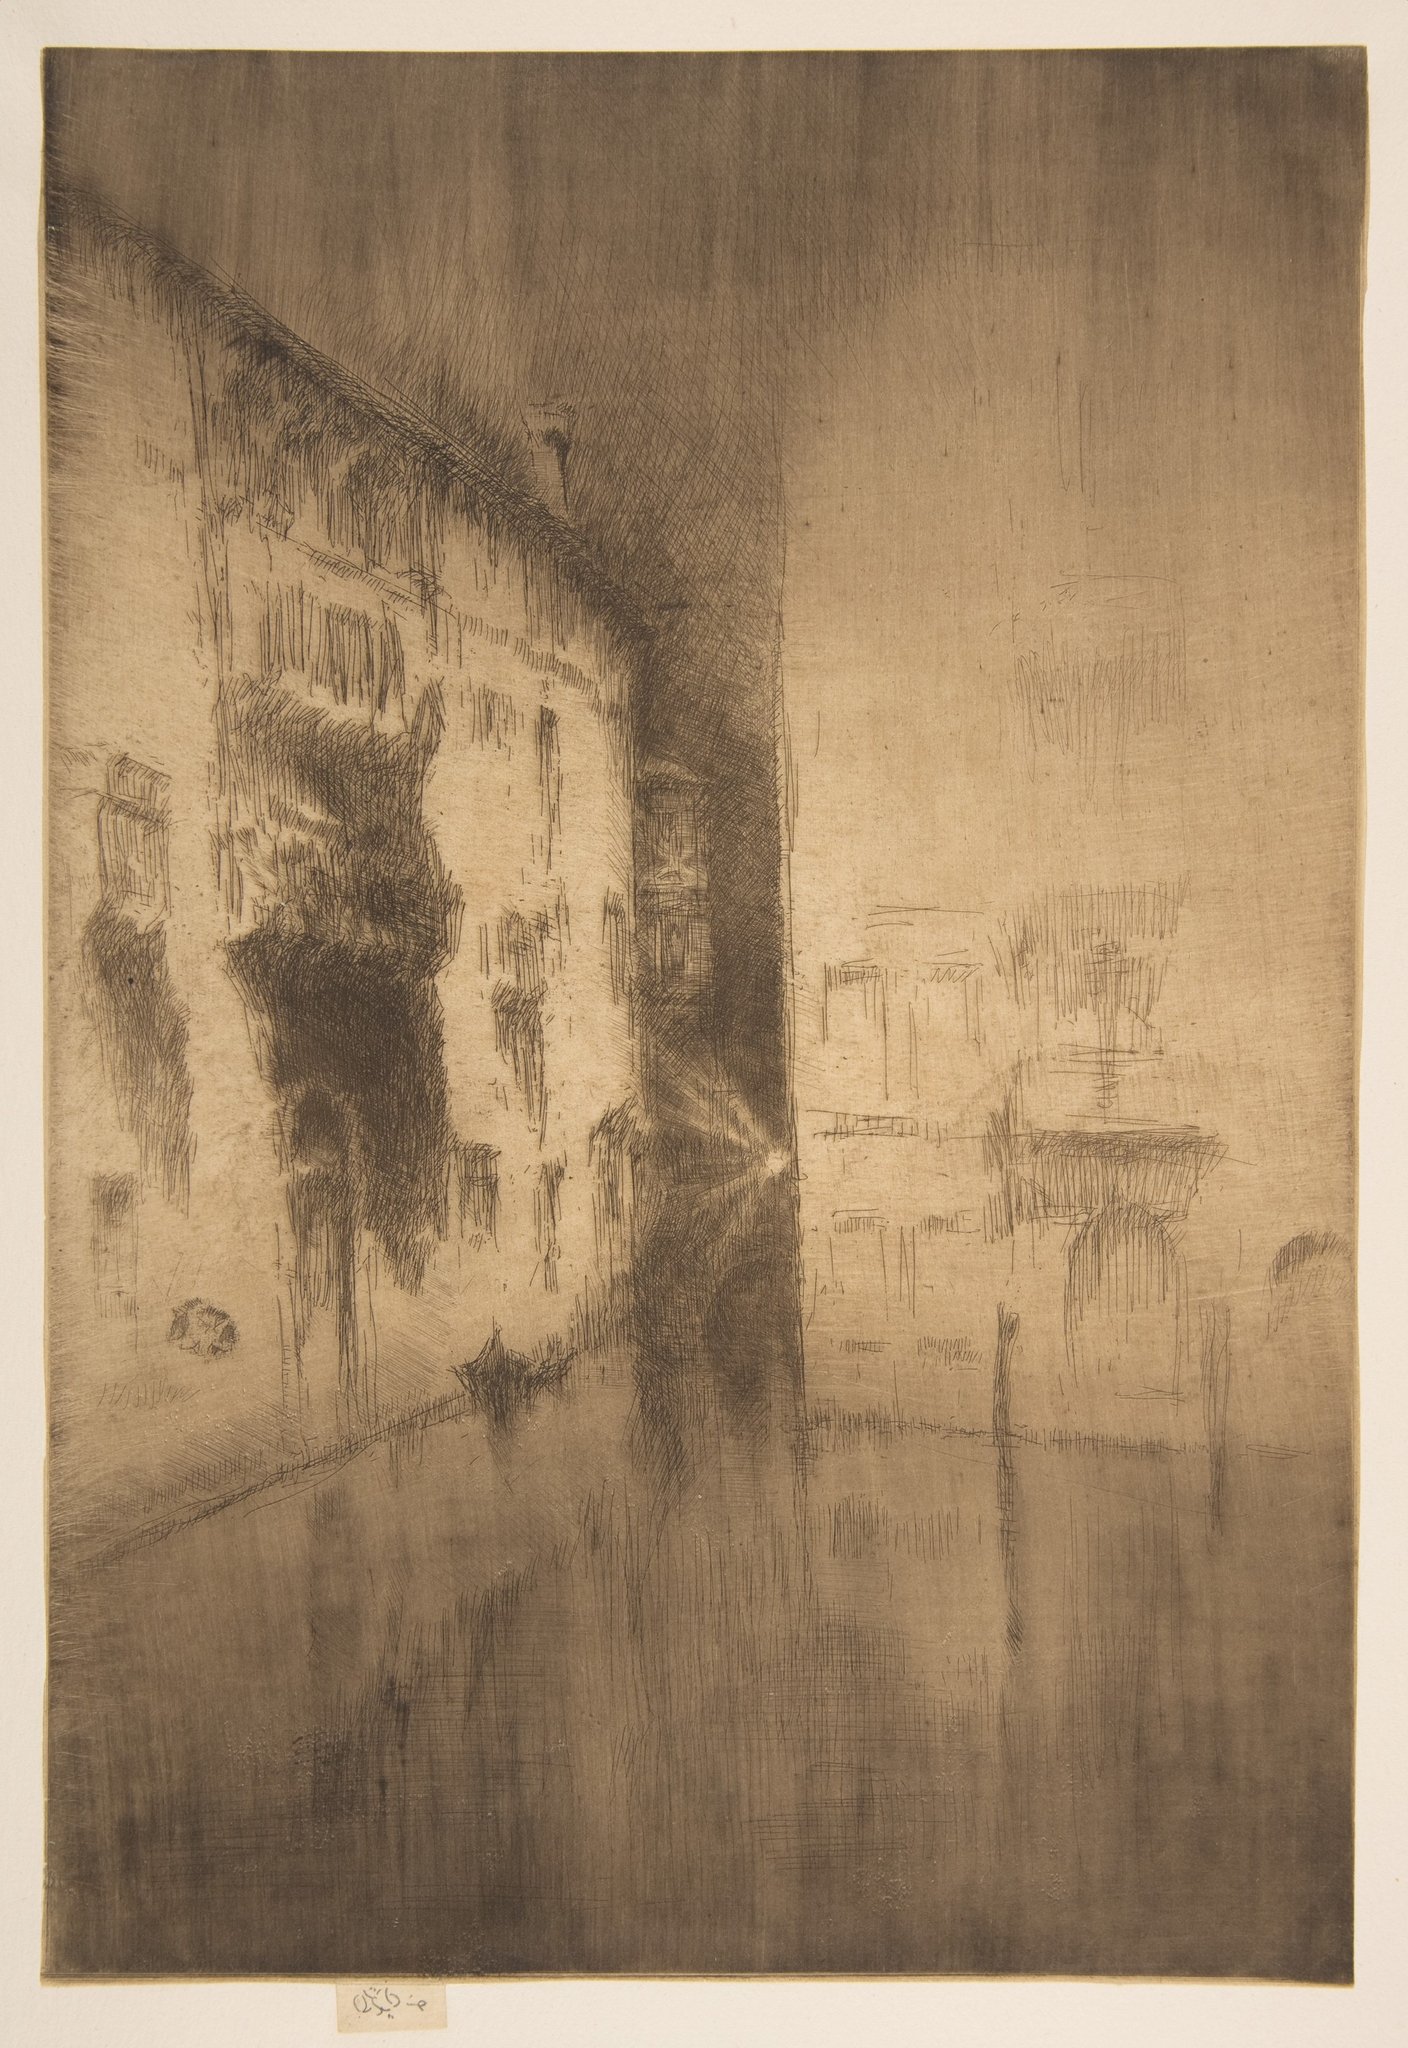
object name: print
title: Nocturne: Palaces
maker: james mcneill whistler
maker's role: artist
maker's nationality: american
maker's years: 1834-1903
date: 1879-1880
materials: ink, paper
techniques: drypoint, etching, printing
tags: buildings,canals,venice